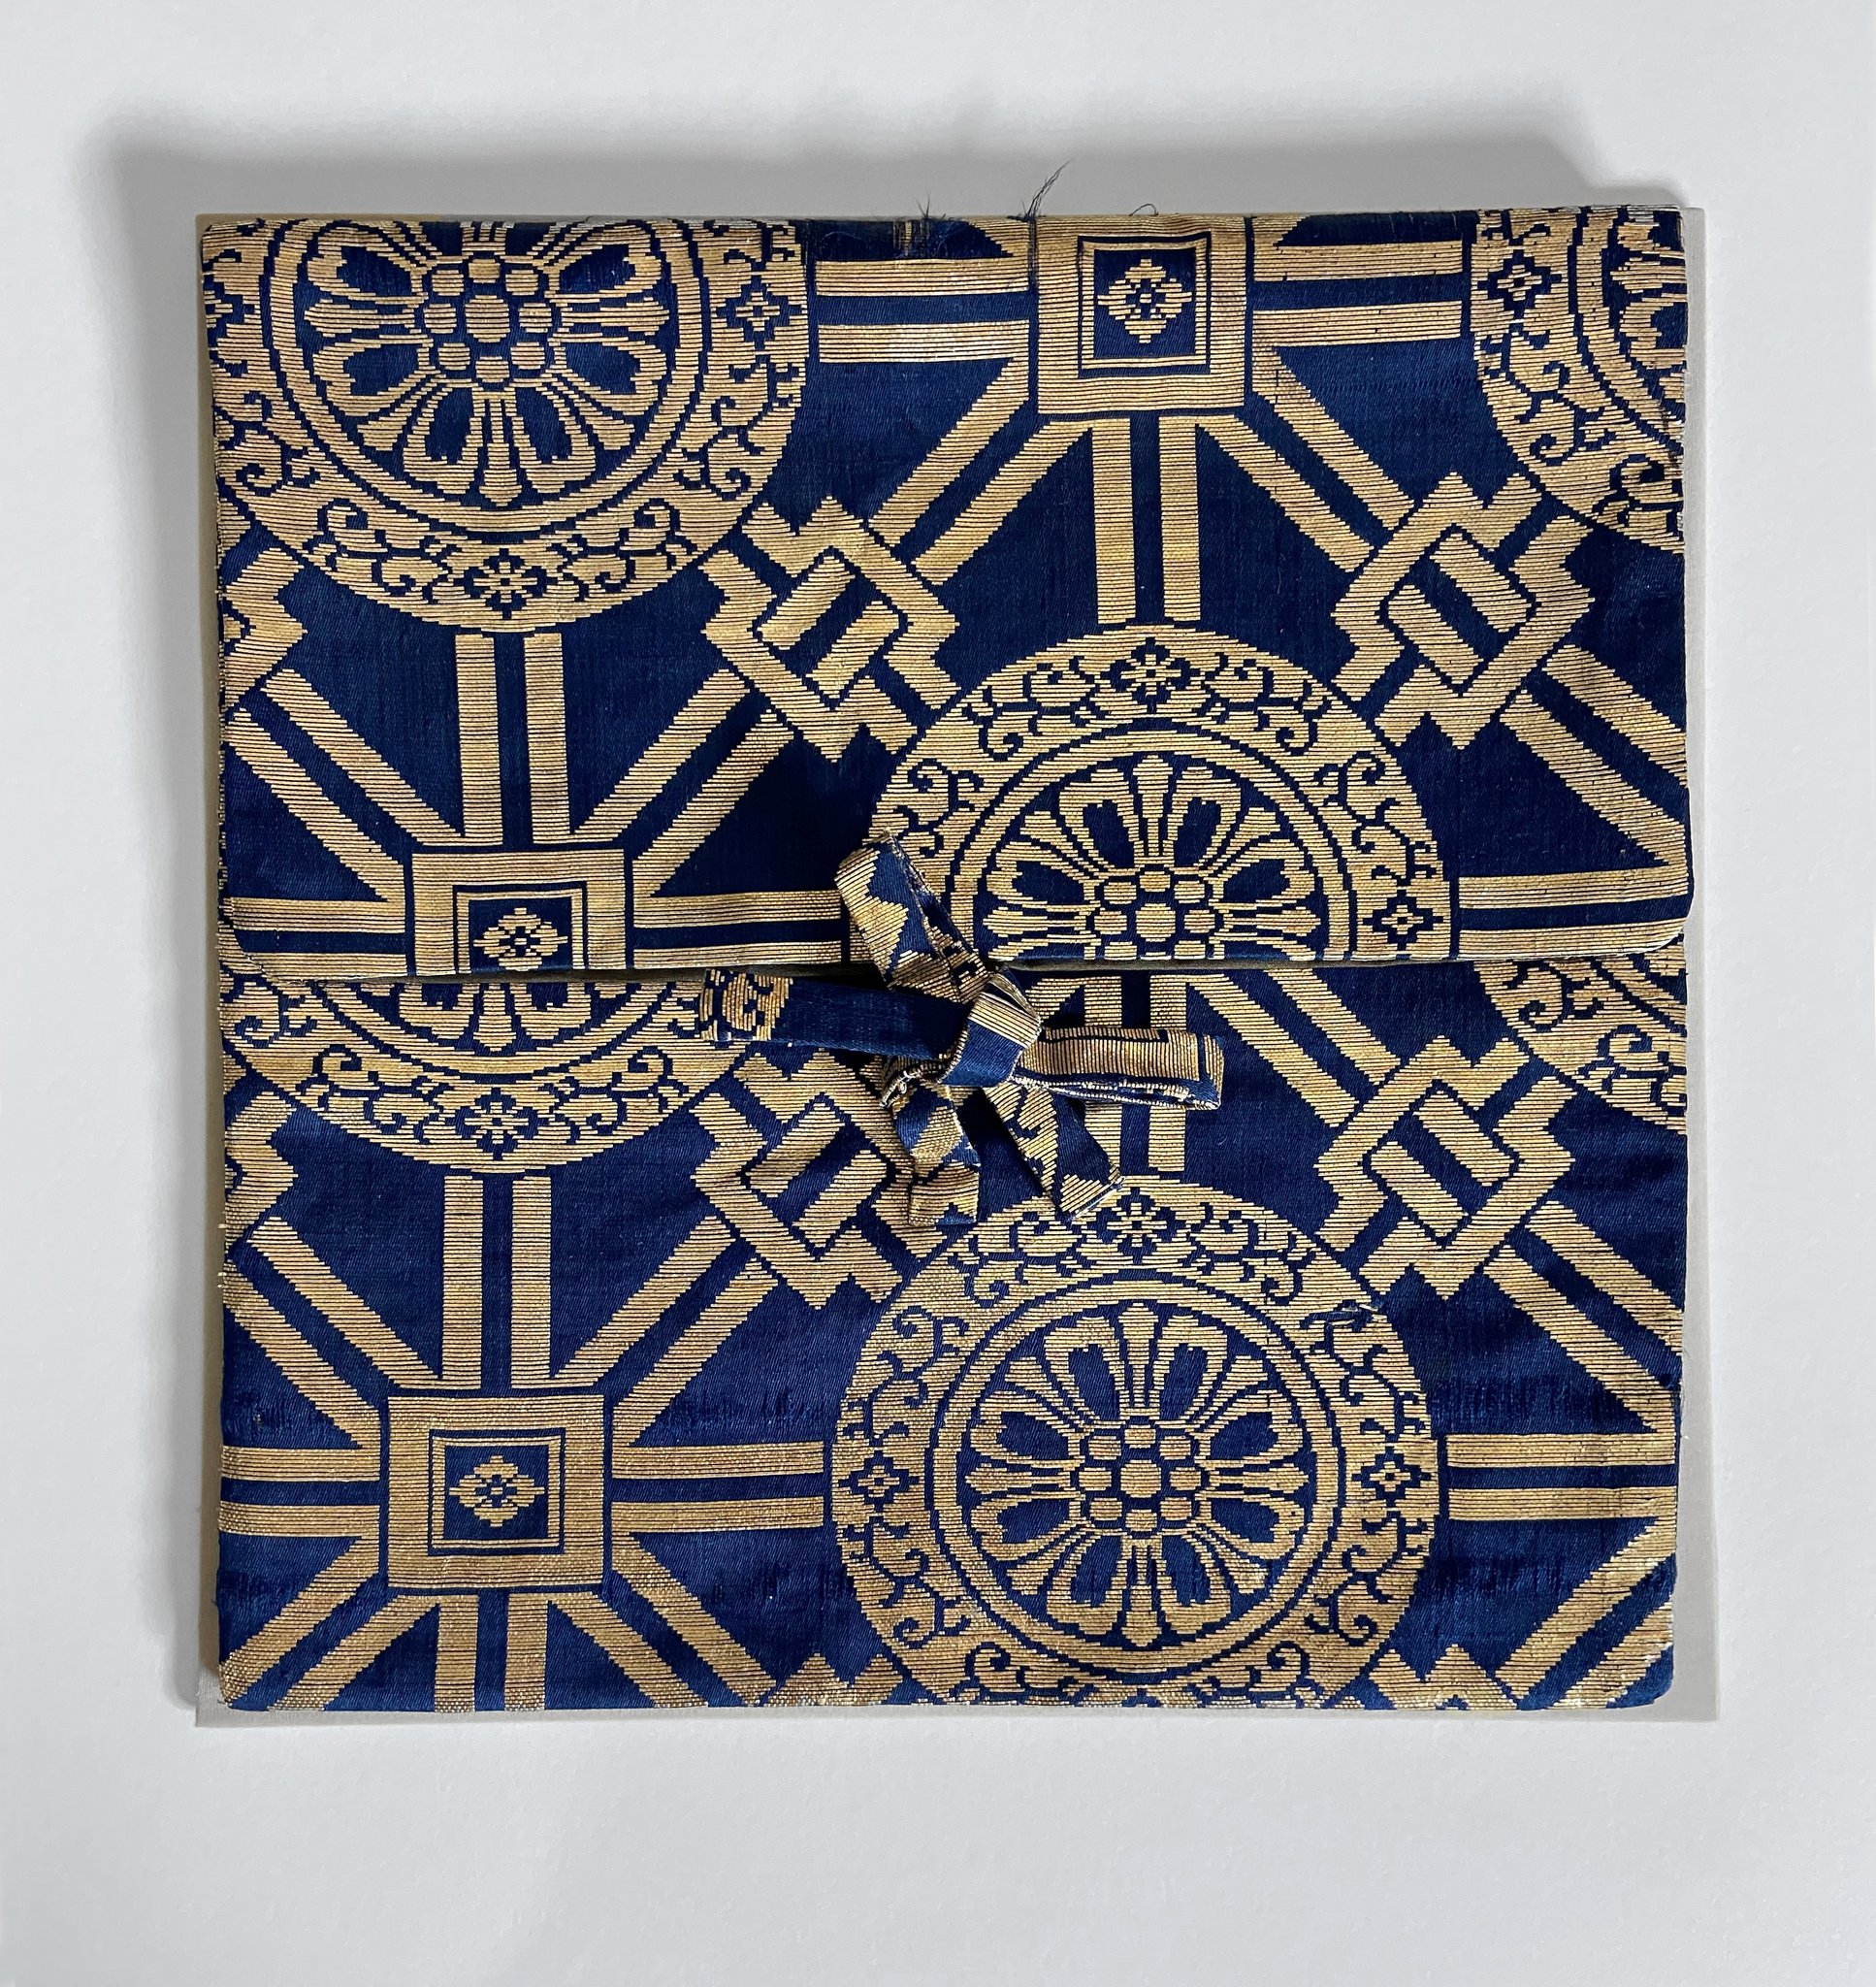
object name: bag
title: Bag for Noh Mask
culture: japanese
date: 1701-1800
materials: silk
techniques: weave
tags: flowers